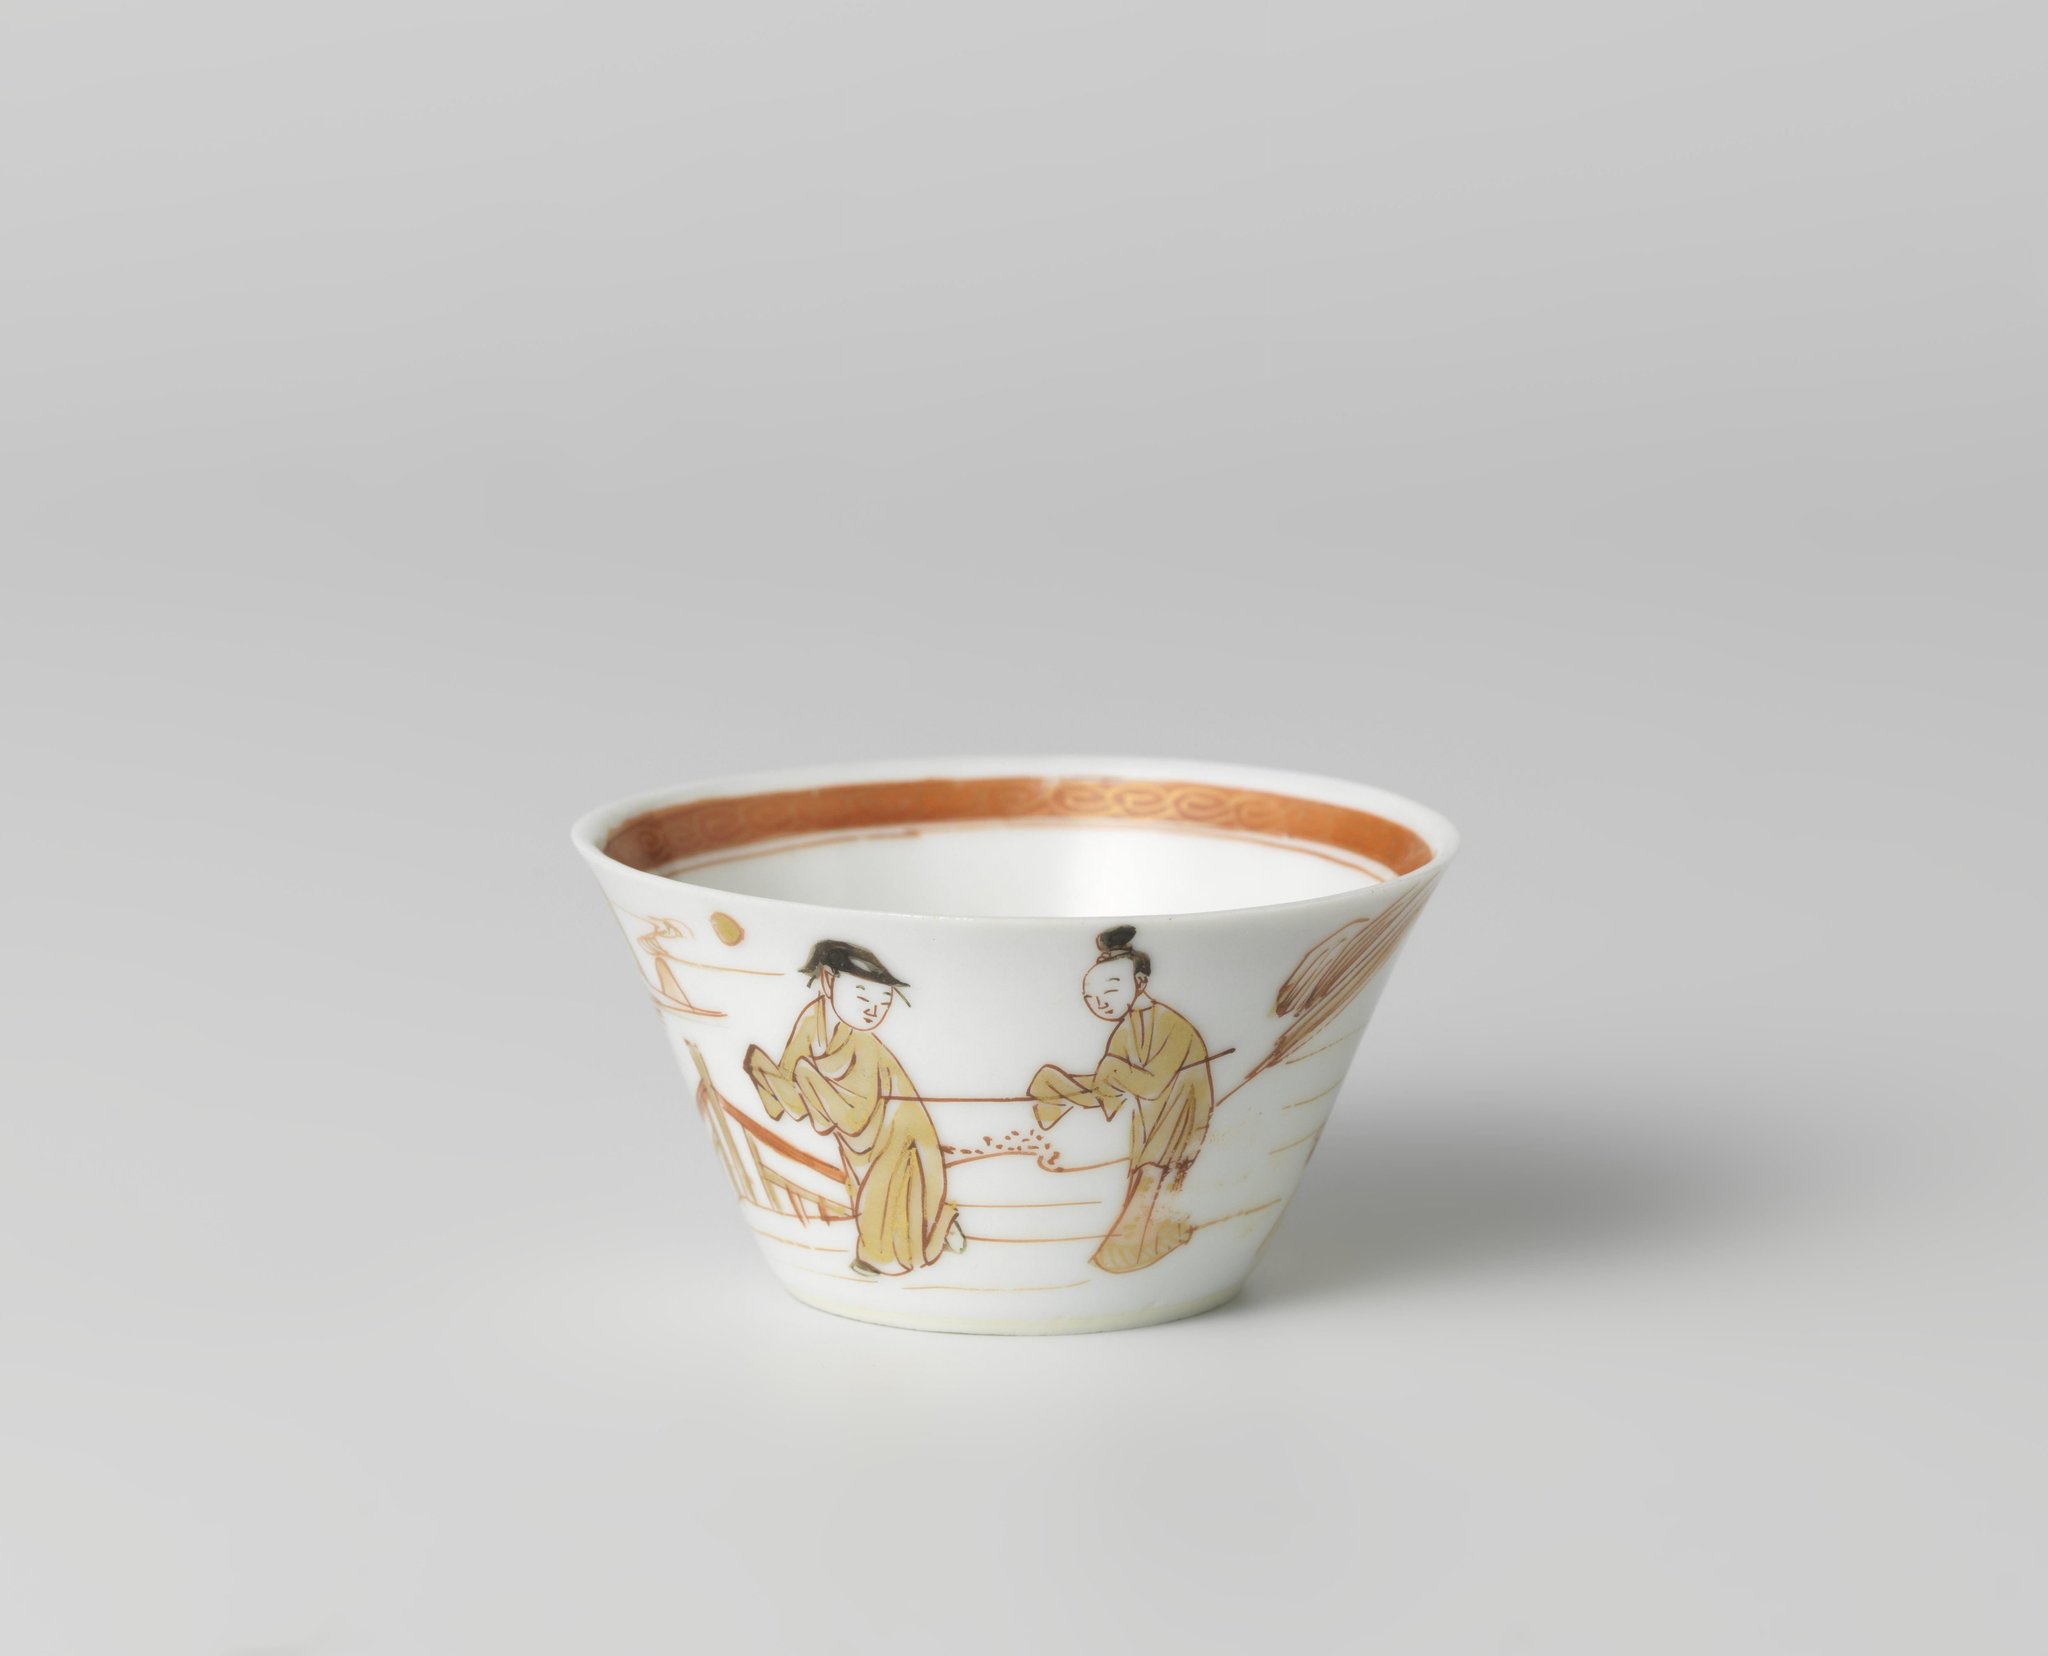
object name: cup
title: Cup with two figures in a water landscape and a flowering tree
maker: Anonymous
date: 1700-1724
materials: glaze, gold, paint, porcelain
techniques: firing, gilding, turning, vitrification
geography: china